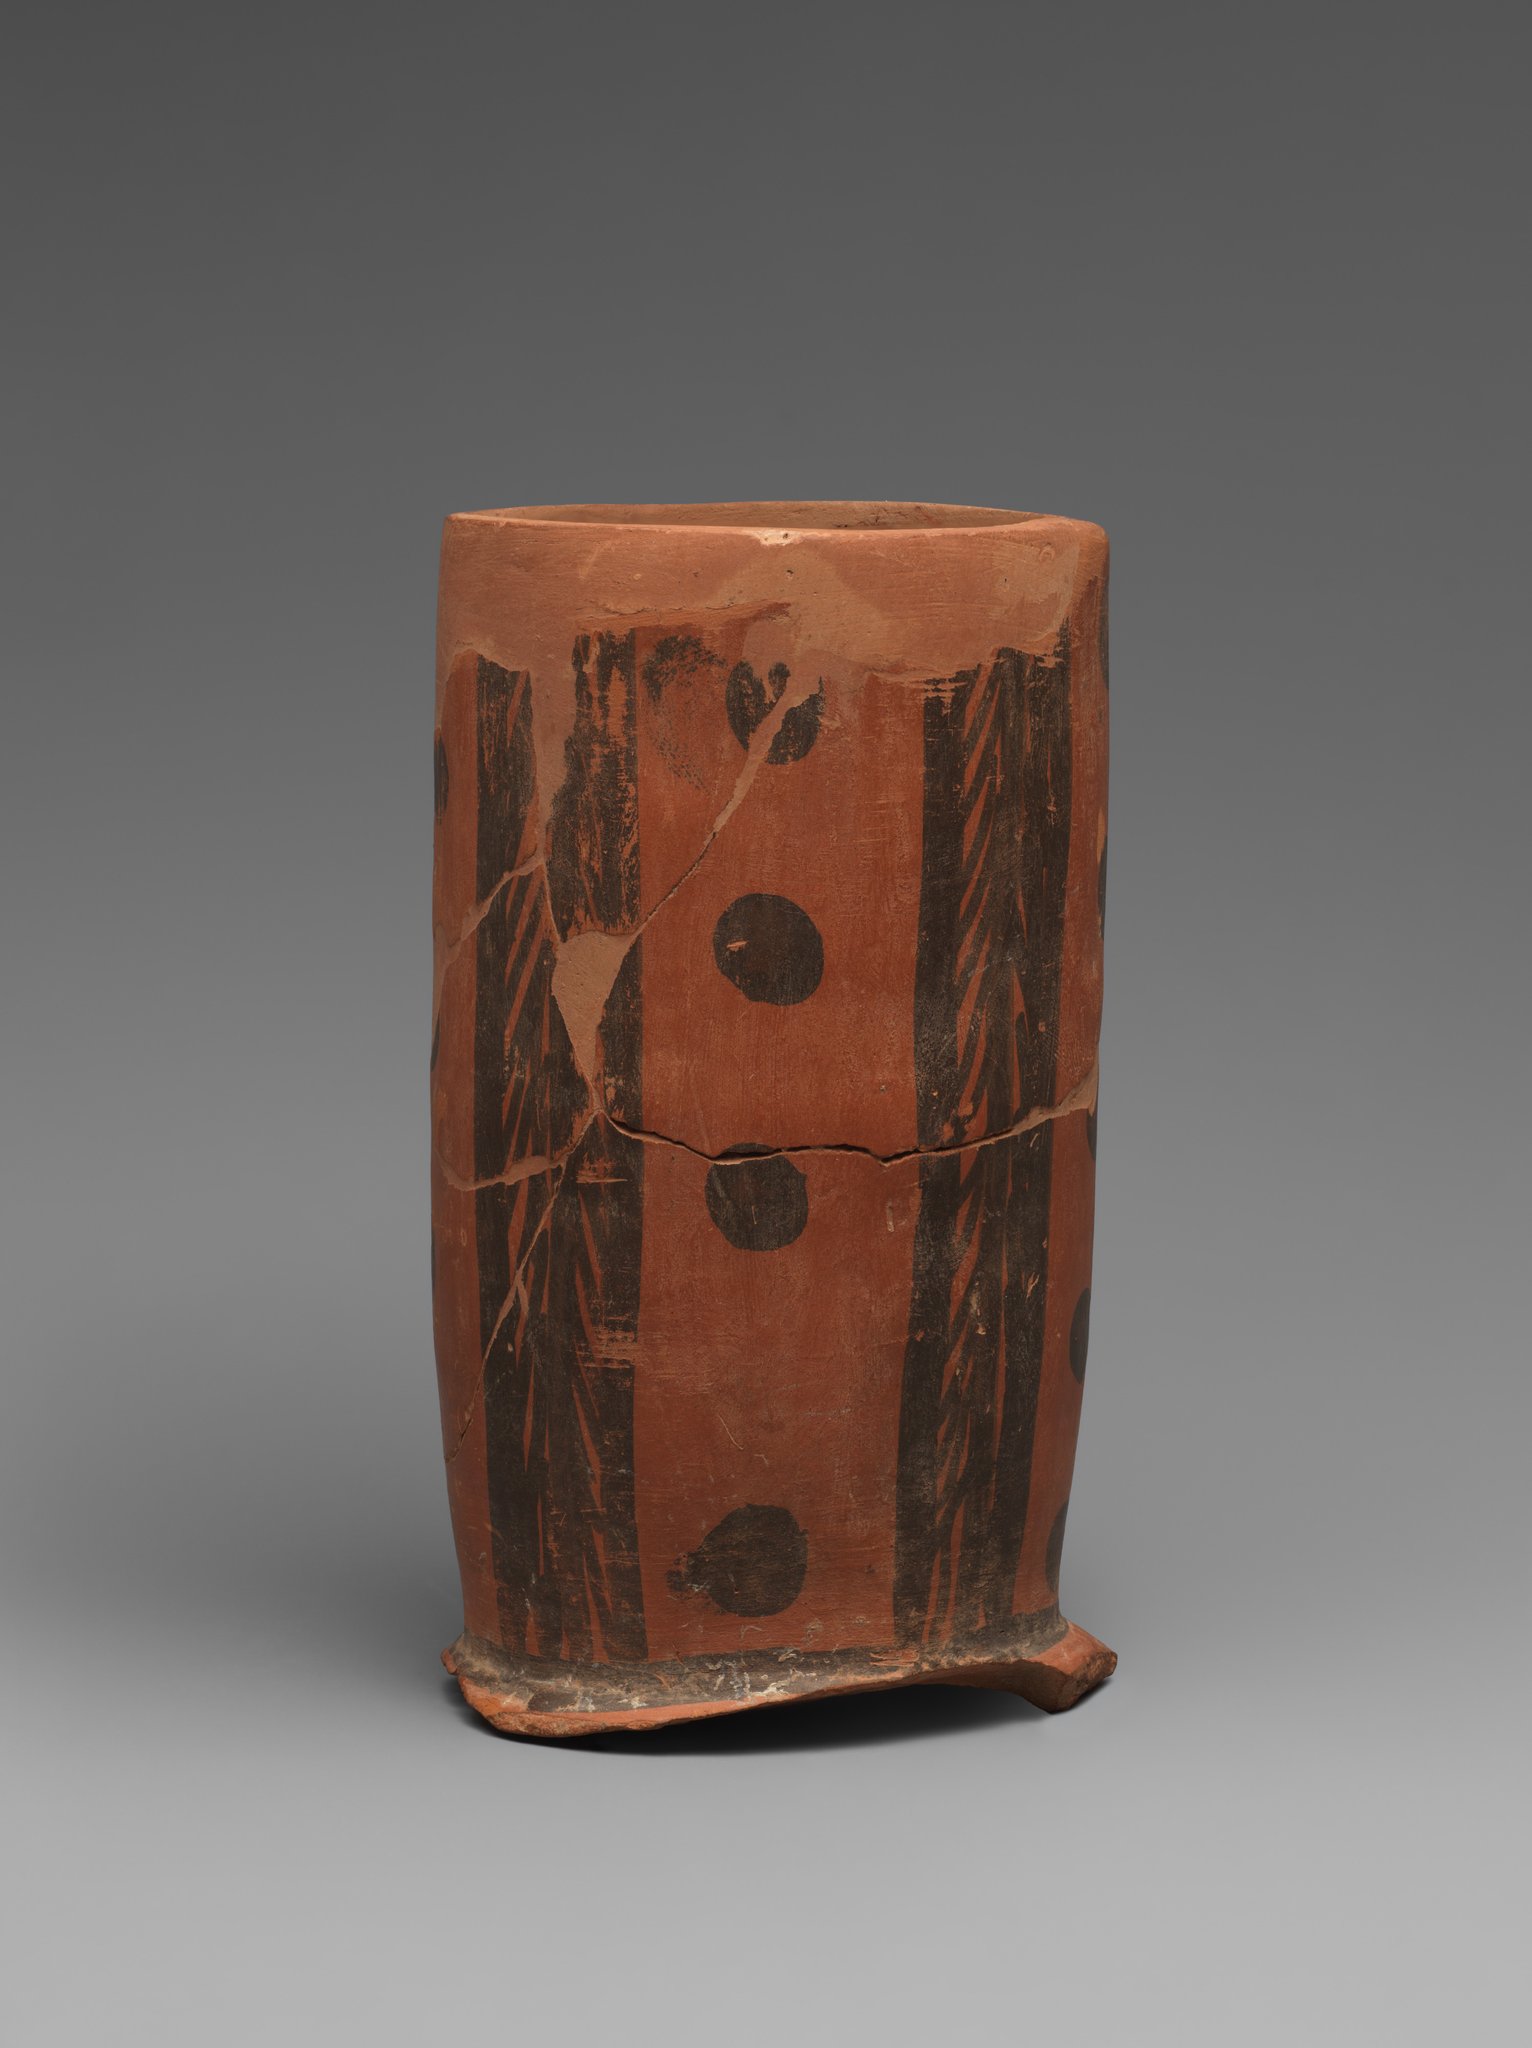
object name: pedestal vase stem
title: Stem of pedestal vase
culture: iranian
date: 3100 BCE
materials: ceramic, paint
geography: iran